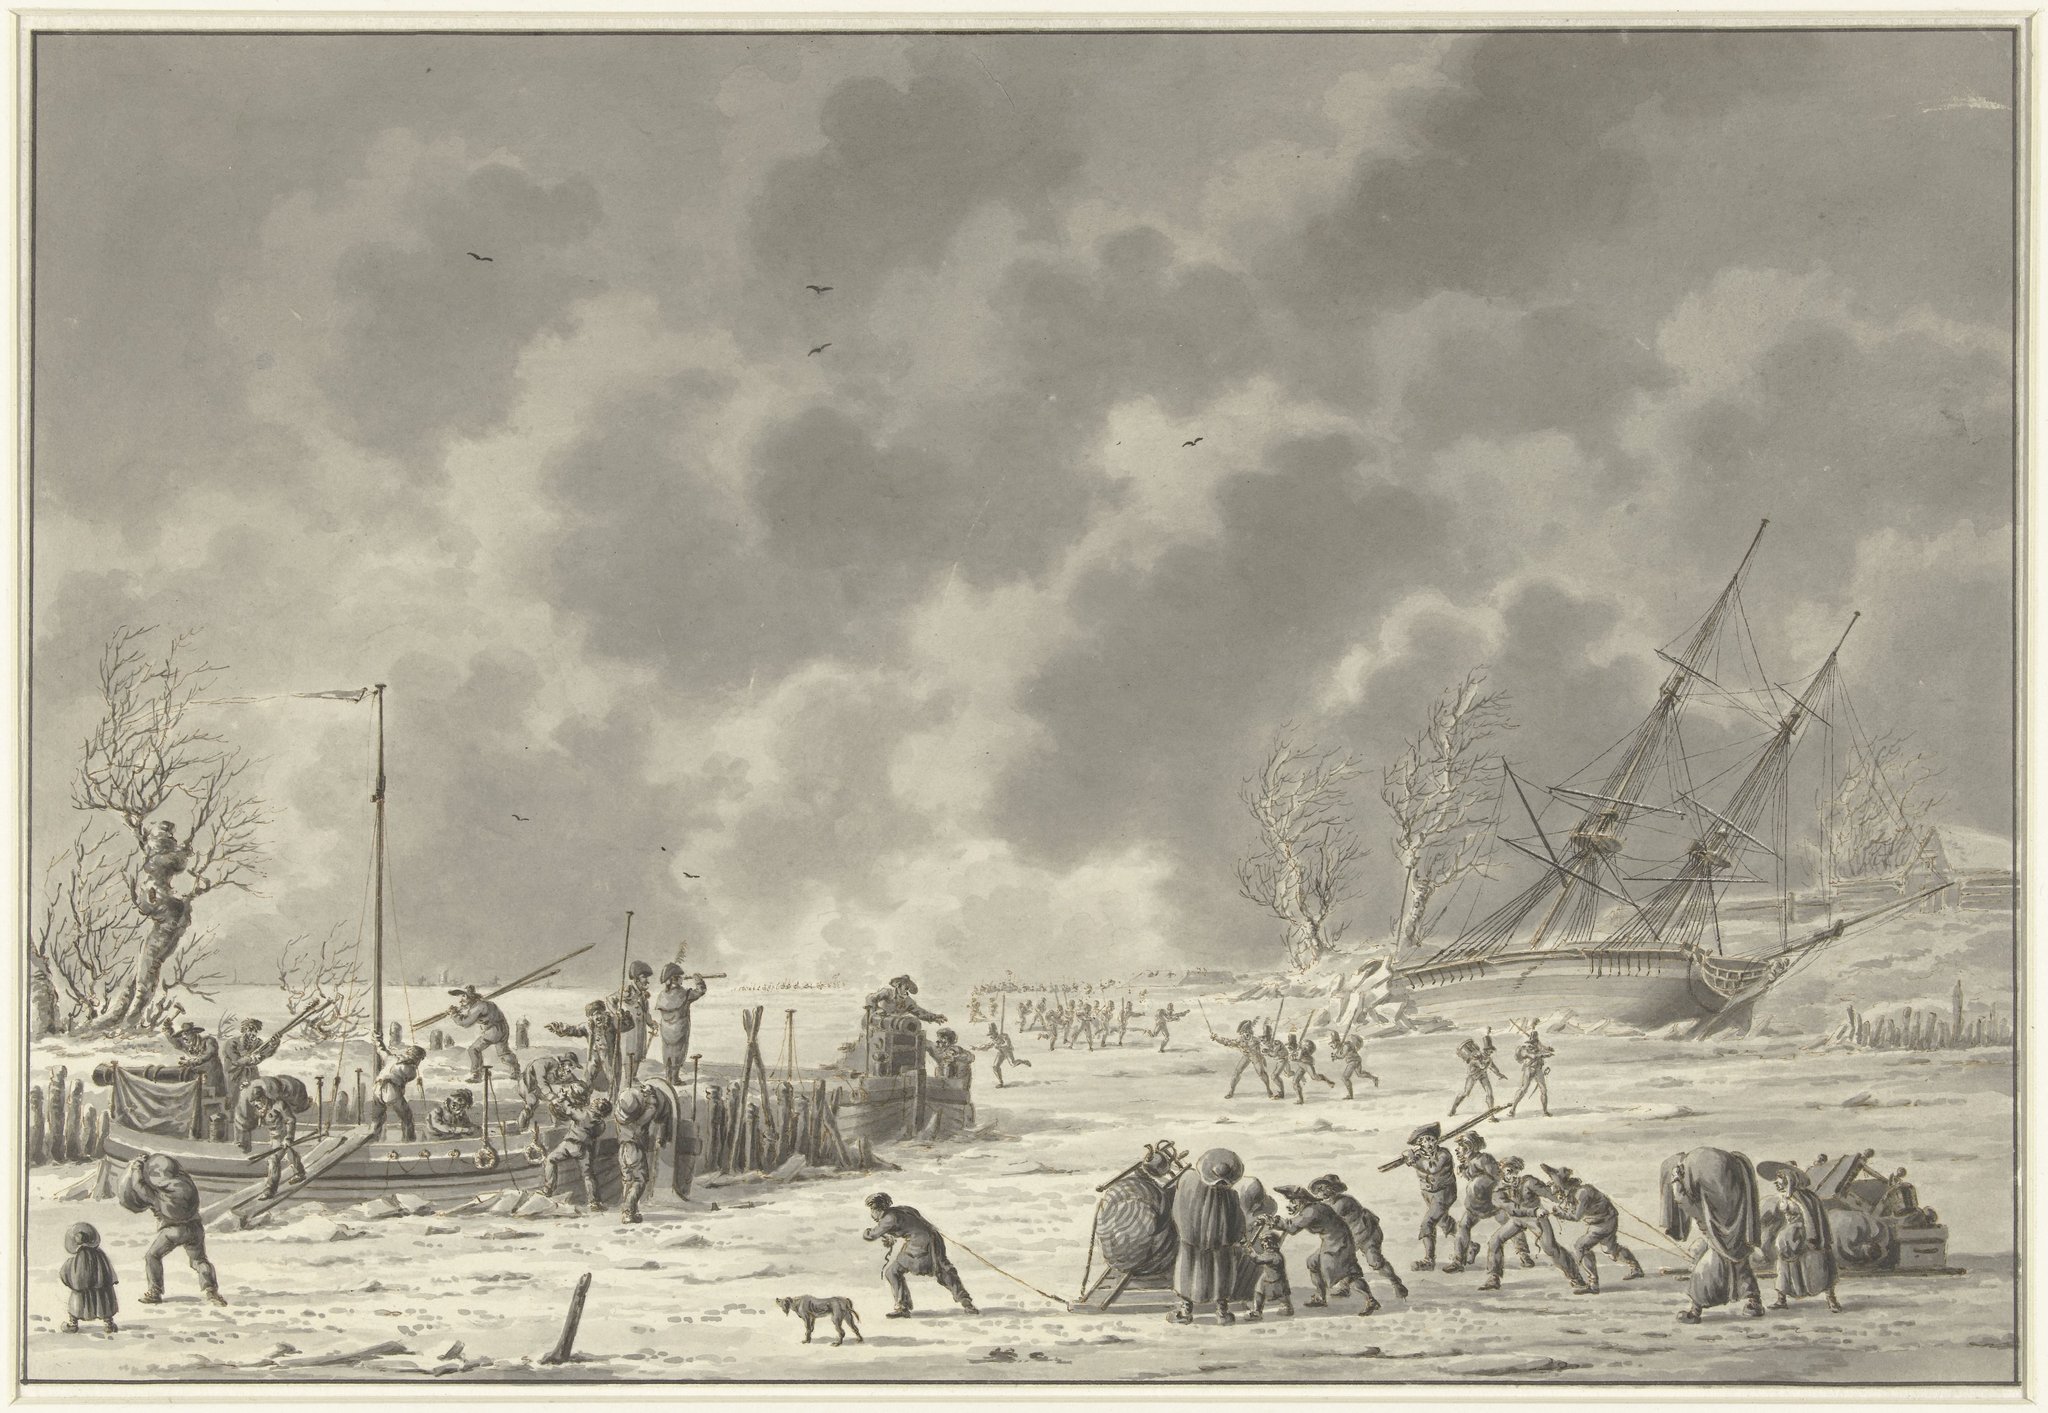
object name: drawing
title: Vluchten van de Landzaten te Texel, december 1794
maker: dirk langendijk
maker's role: draughtsman, painter, print maker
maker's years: 1748-1805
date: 1794-1795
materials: paper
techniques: brush, pen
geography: netherlands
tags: putting the enemy to flight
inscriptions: annotation: ‘Het verlaeten der Canoneer Booten en de Vlugt der Land Zaeten in de Maand December 1795’, collector's mark: Lugt 2228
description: Het verlaten van de in het ijs vastgevroren kanonneerboten bij Texel en het vluchten van de Landzaten, december 1794. Een kanonnerboot wordt ontmanteld en het kanon onklaar gemaakt. Verschillende groepen mensen trekken huisraad op sledes over het ijs. Op de achtergrond de naderende Franse troepen.